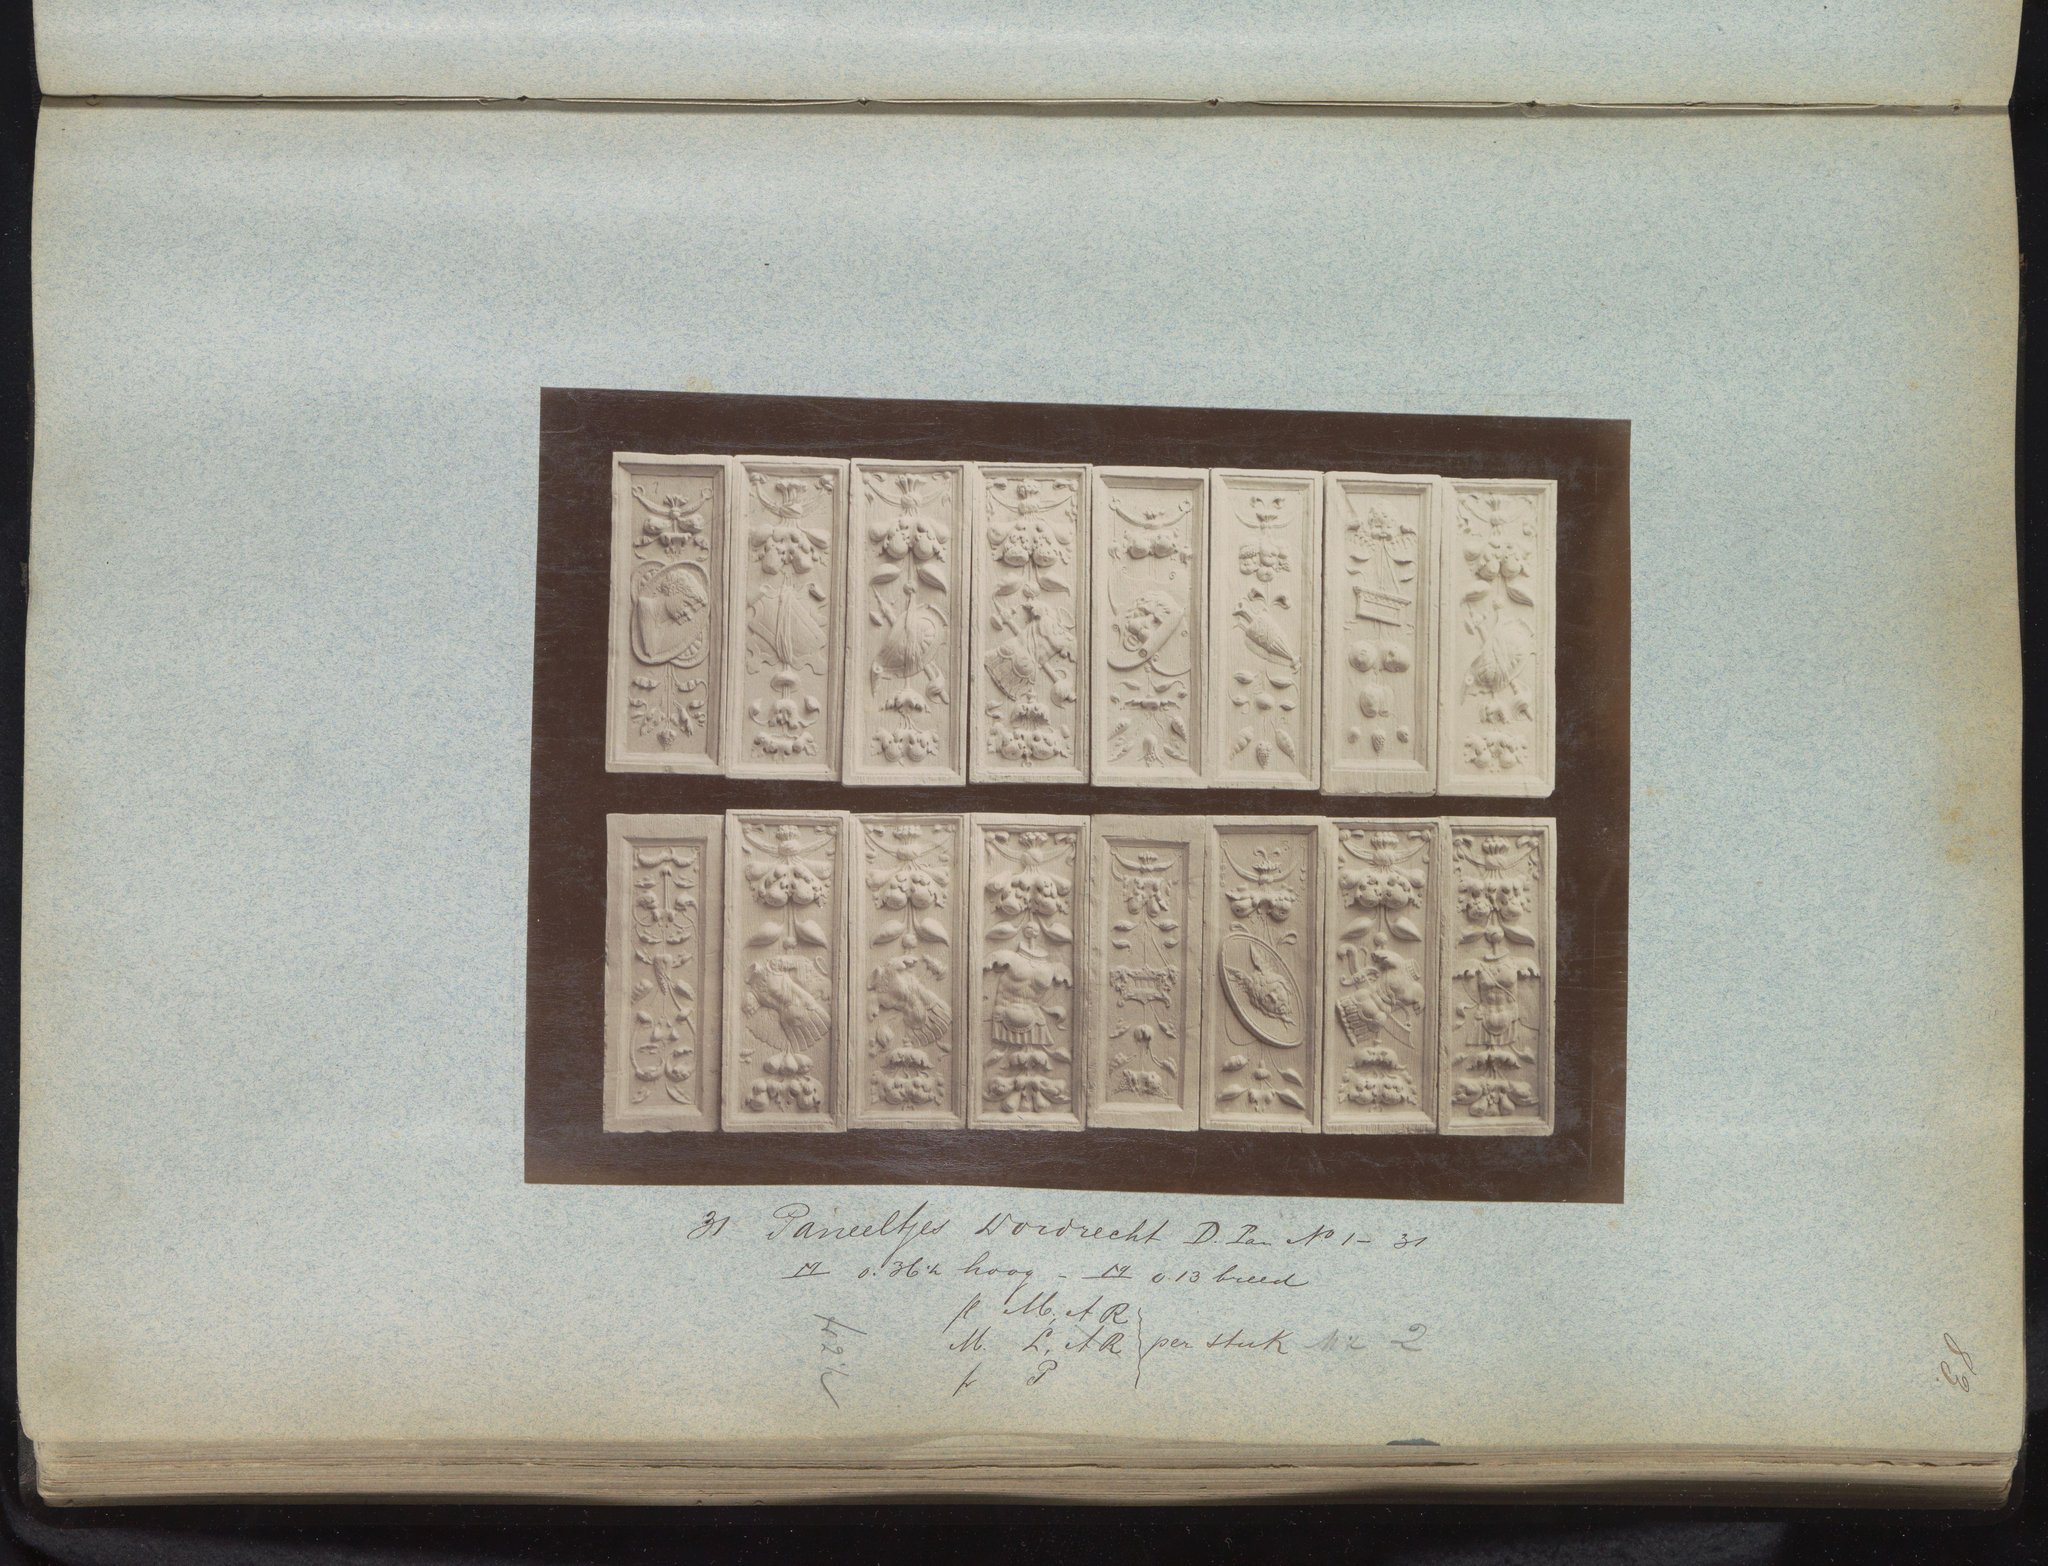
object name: photograph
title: Gipsen afgietsels van paneeltjes uit een kerk te Dordrecht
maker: Anonymous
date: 1875-1900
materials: paper, photographic support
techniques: albumen print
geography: dordrecht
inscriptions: annotation, annotation: ‘31 Paneeltjes Dordrecht / M 0.36 1/1 hoog - M 0.13 breed’